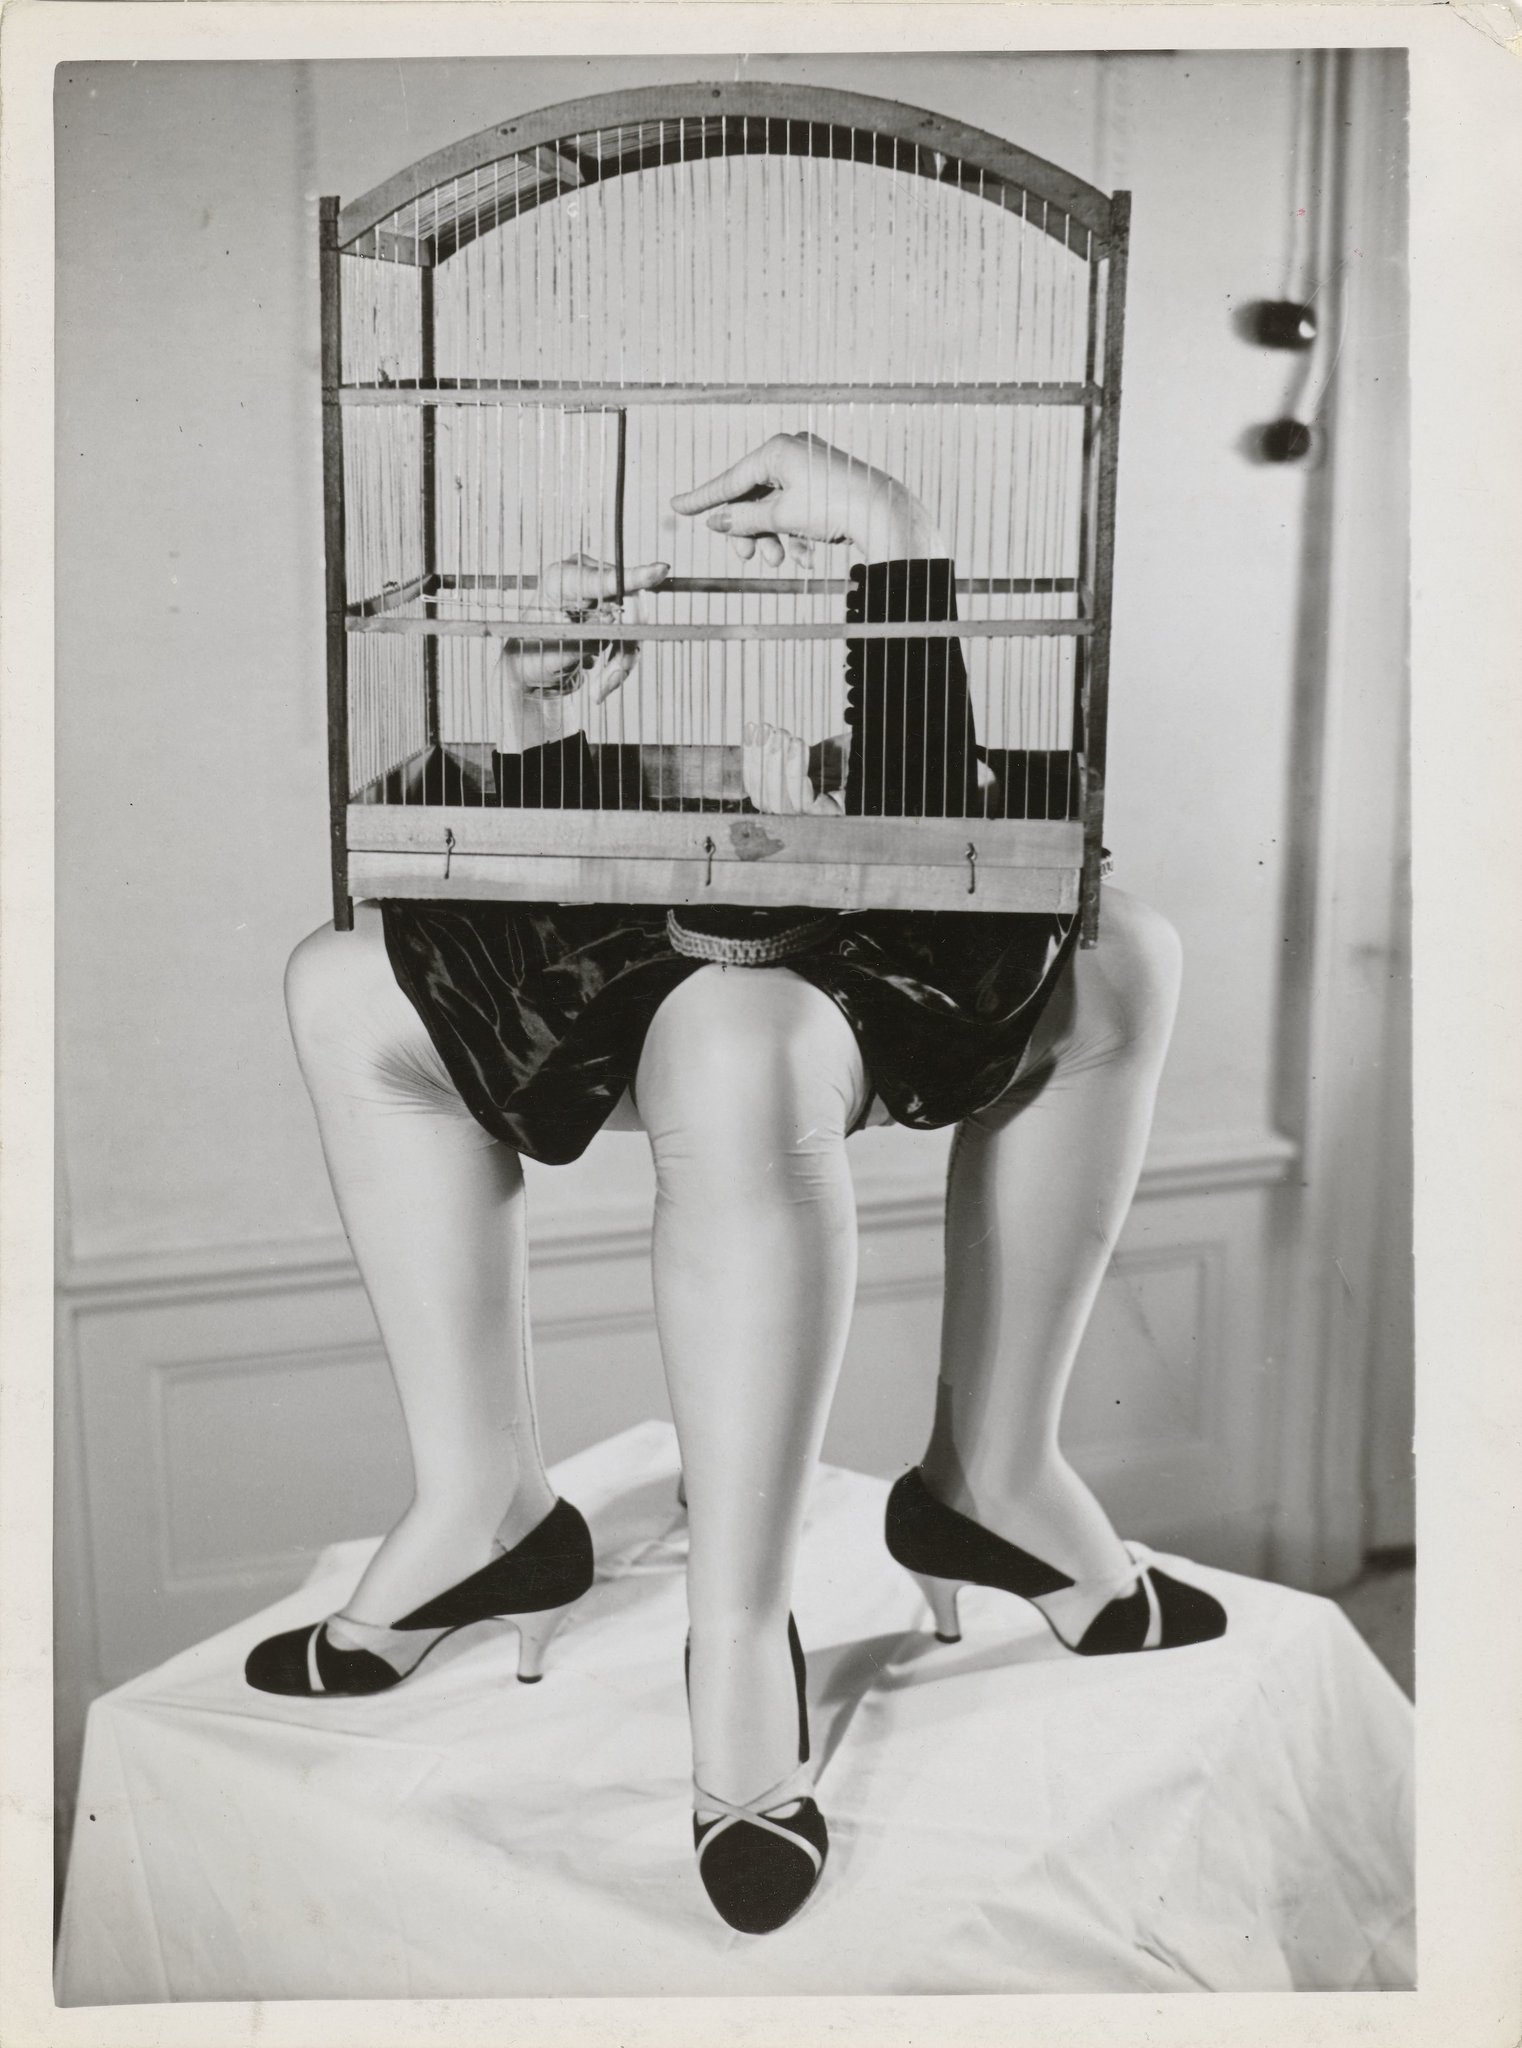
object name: photograph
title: Een typisch voorbeeld van surrealisme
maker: Anonymous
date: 1938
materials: photographic support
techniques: gelatin silver print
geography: amsterdam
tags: amsterdam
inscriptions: stamp: ‘N.V. Polygoon’, inscription: ‘6380813 Amsterdam 3.6.38 morgen wordt te Amsterdam een tentoonstelling van (internationaal) surrealistische kunst gehouden een tijpisch voorbeeld van surrealisme’, stamp: ‘Galerie Robert Keizersgracht 527 Amsterdam’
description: Onderdeel van een serie betreffende een reizende tentoonstelling "Exposition Internationale du Surréalisme", in galerie Robert te Amsterdam